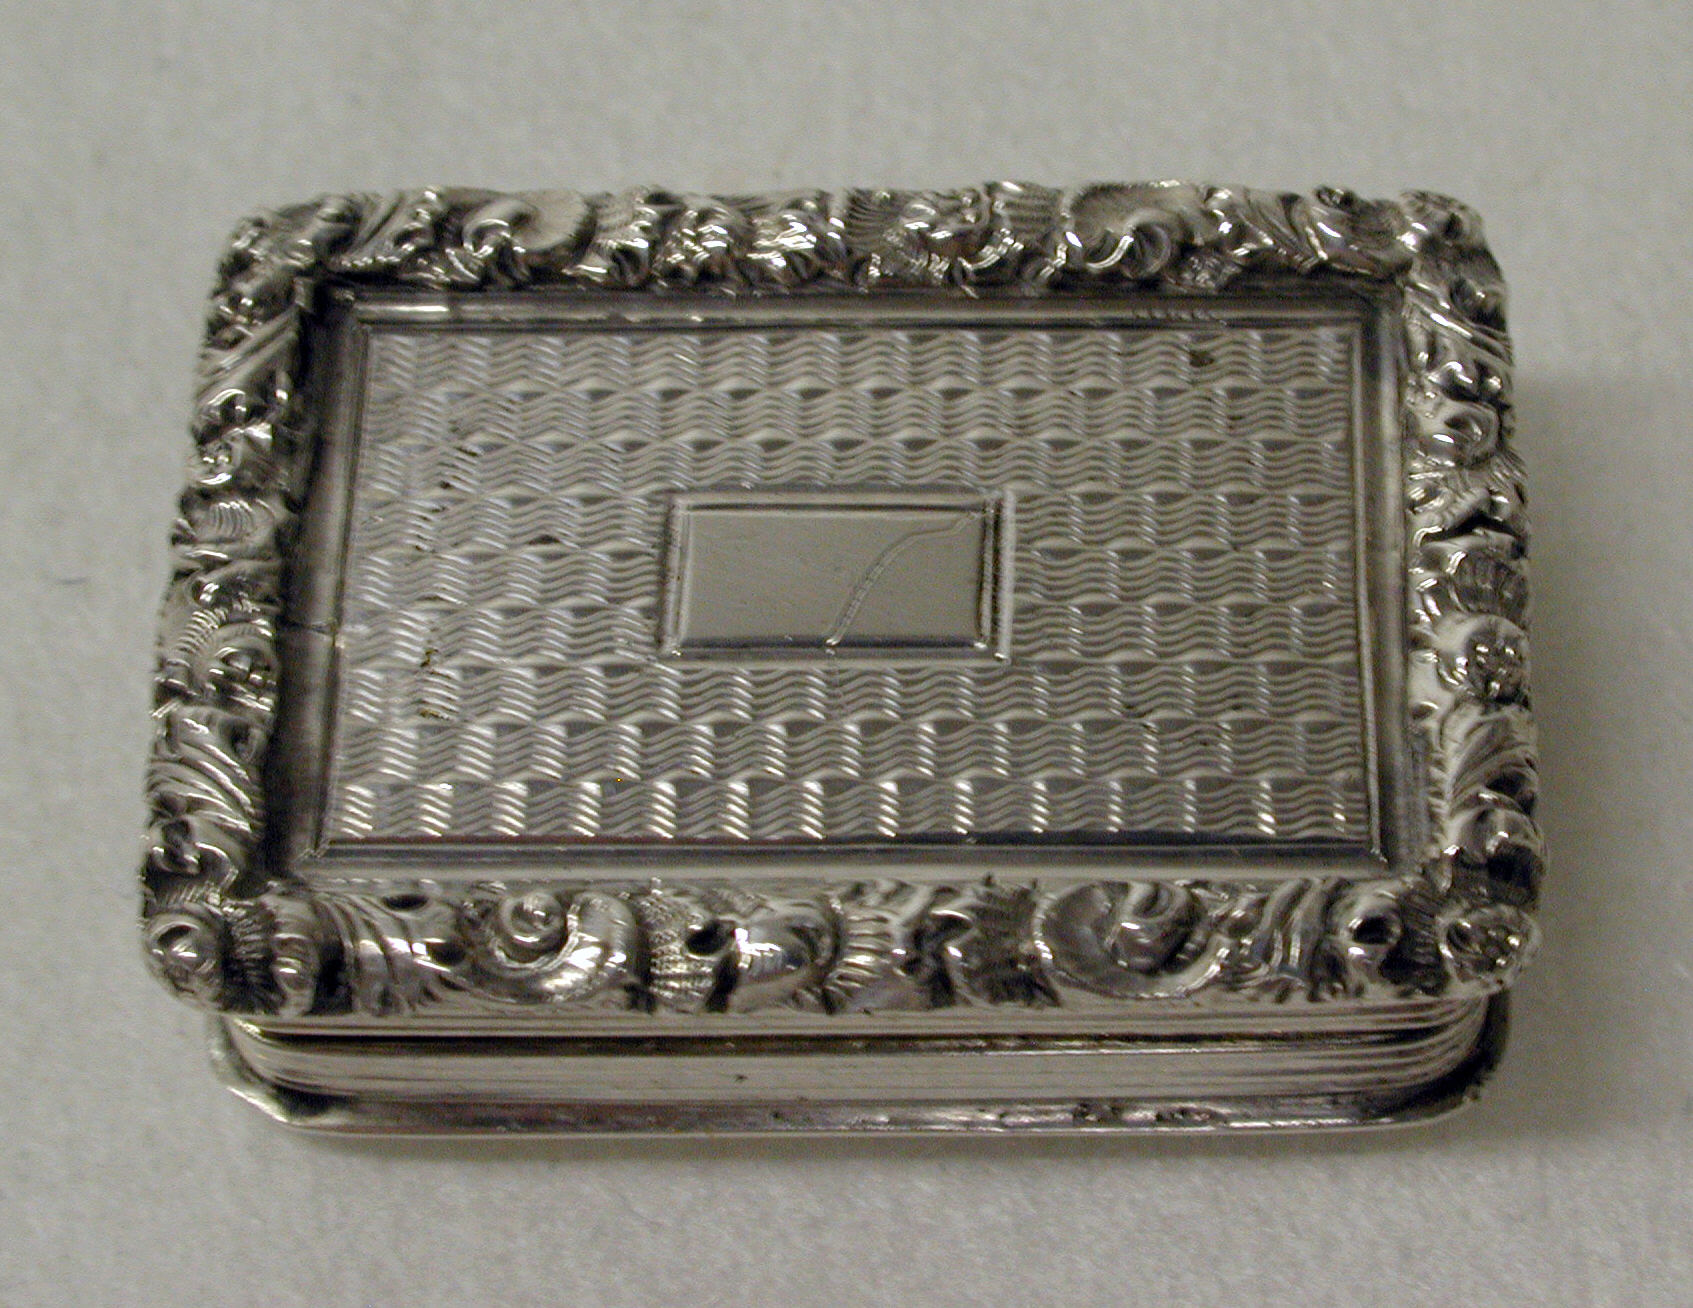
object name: vinaigrette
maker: nathaniel mills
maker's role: maker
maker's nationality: british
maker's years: 1746-1843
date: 1834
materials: silver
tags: flowers